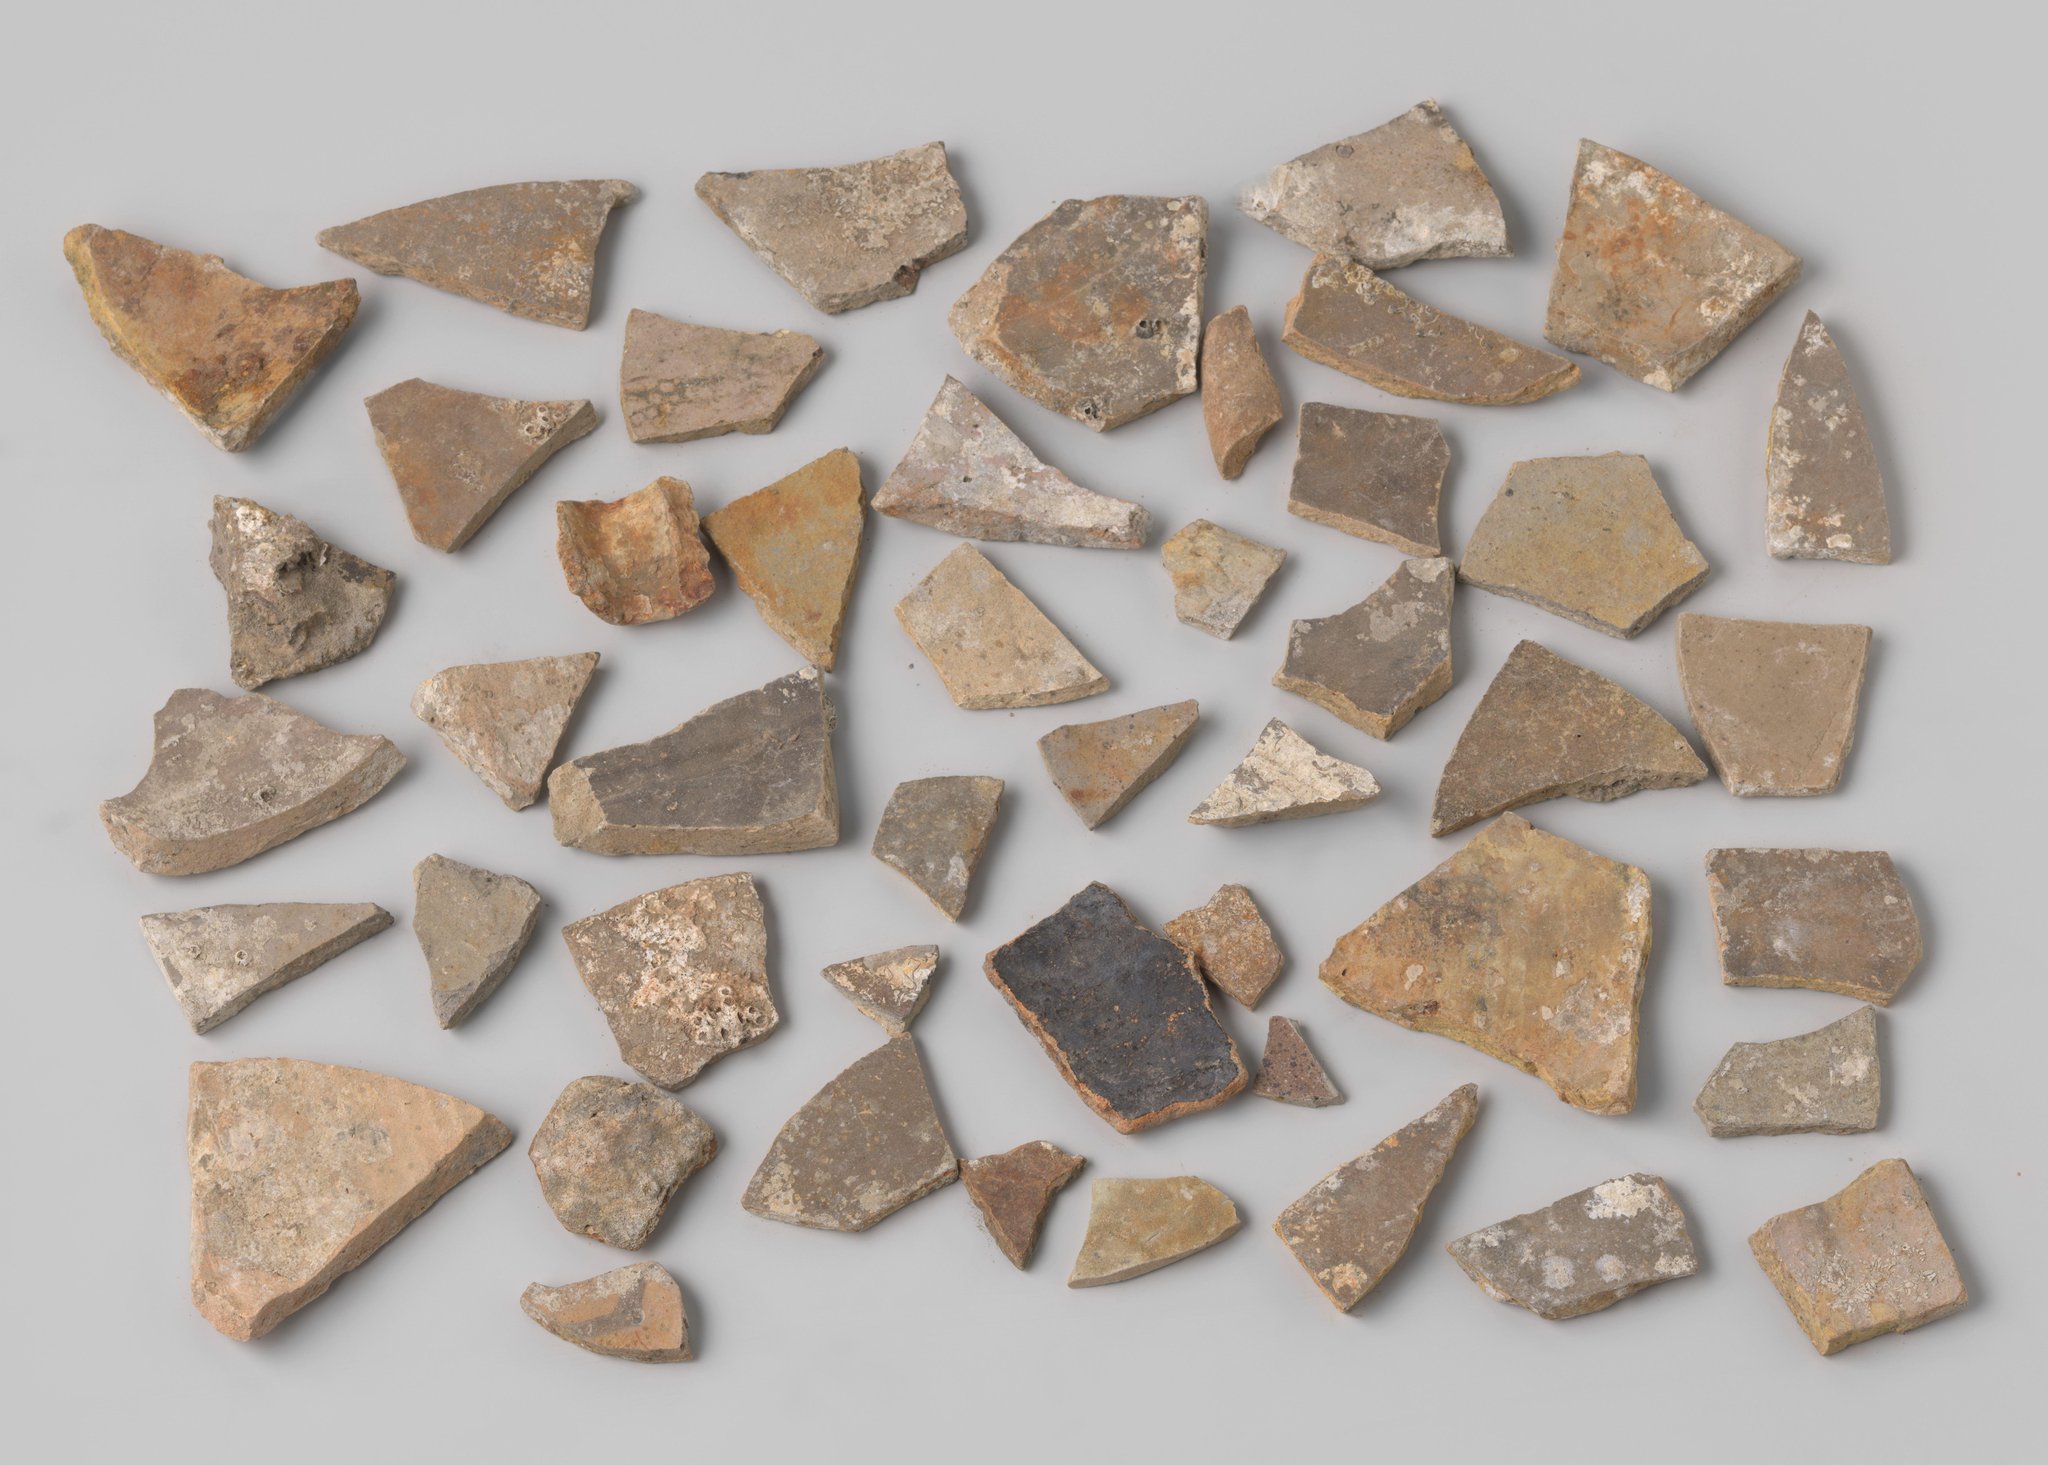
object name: sherd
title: Scherven van martavanen uit V.O.C.-schip de 'Witte Leeuw'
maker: Anonymous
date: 1613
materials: porcelain, stoneware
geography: southeast asia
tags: verenigde oostindische compagnie, sint-helena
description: A jar. The interior and exterior is covered by a dark grey and reddish glaze. The base and lower part of the waist is unglazed and has a yellow surface. There is a grey-yellow band on the shoulder, a few centimeters beneath the ears, where the glaze has come off due to another jar having been placed over this one during firing process.